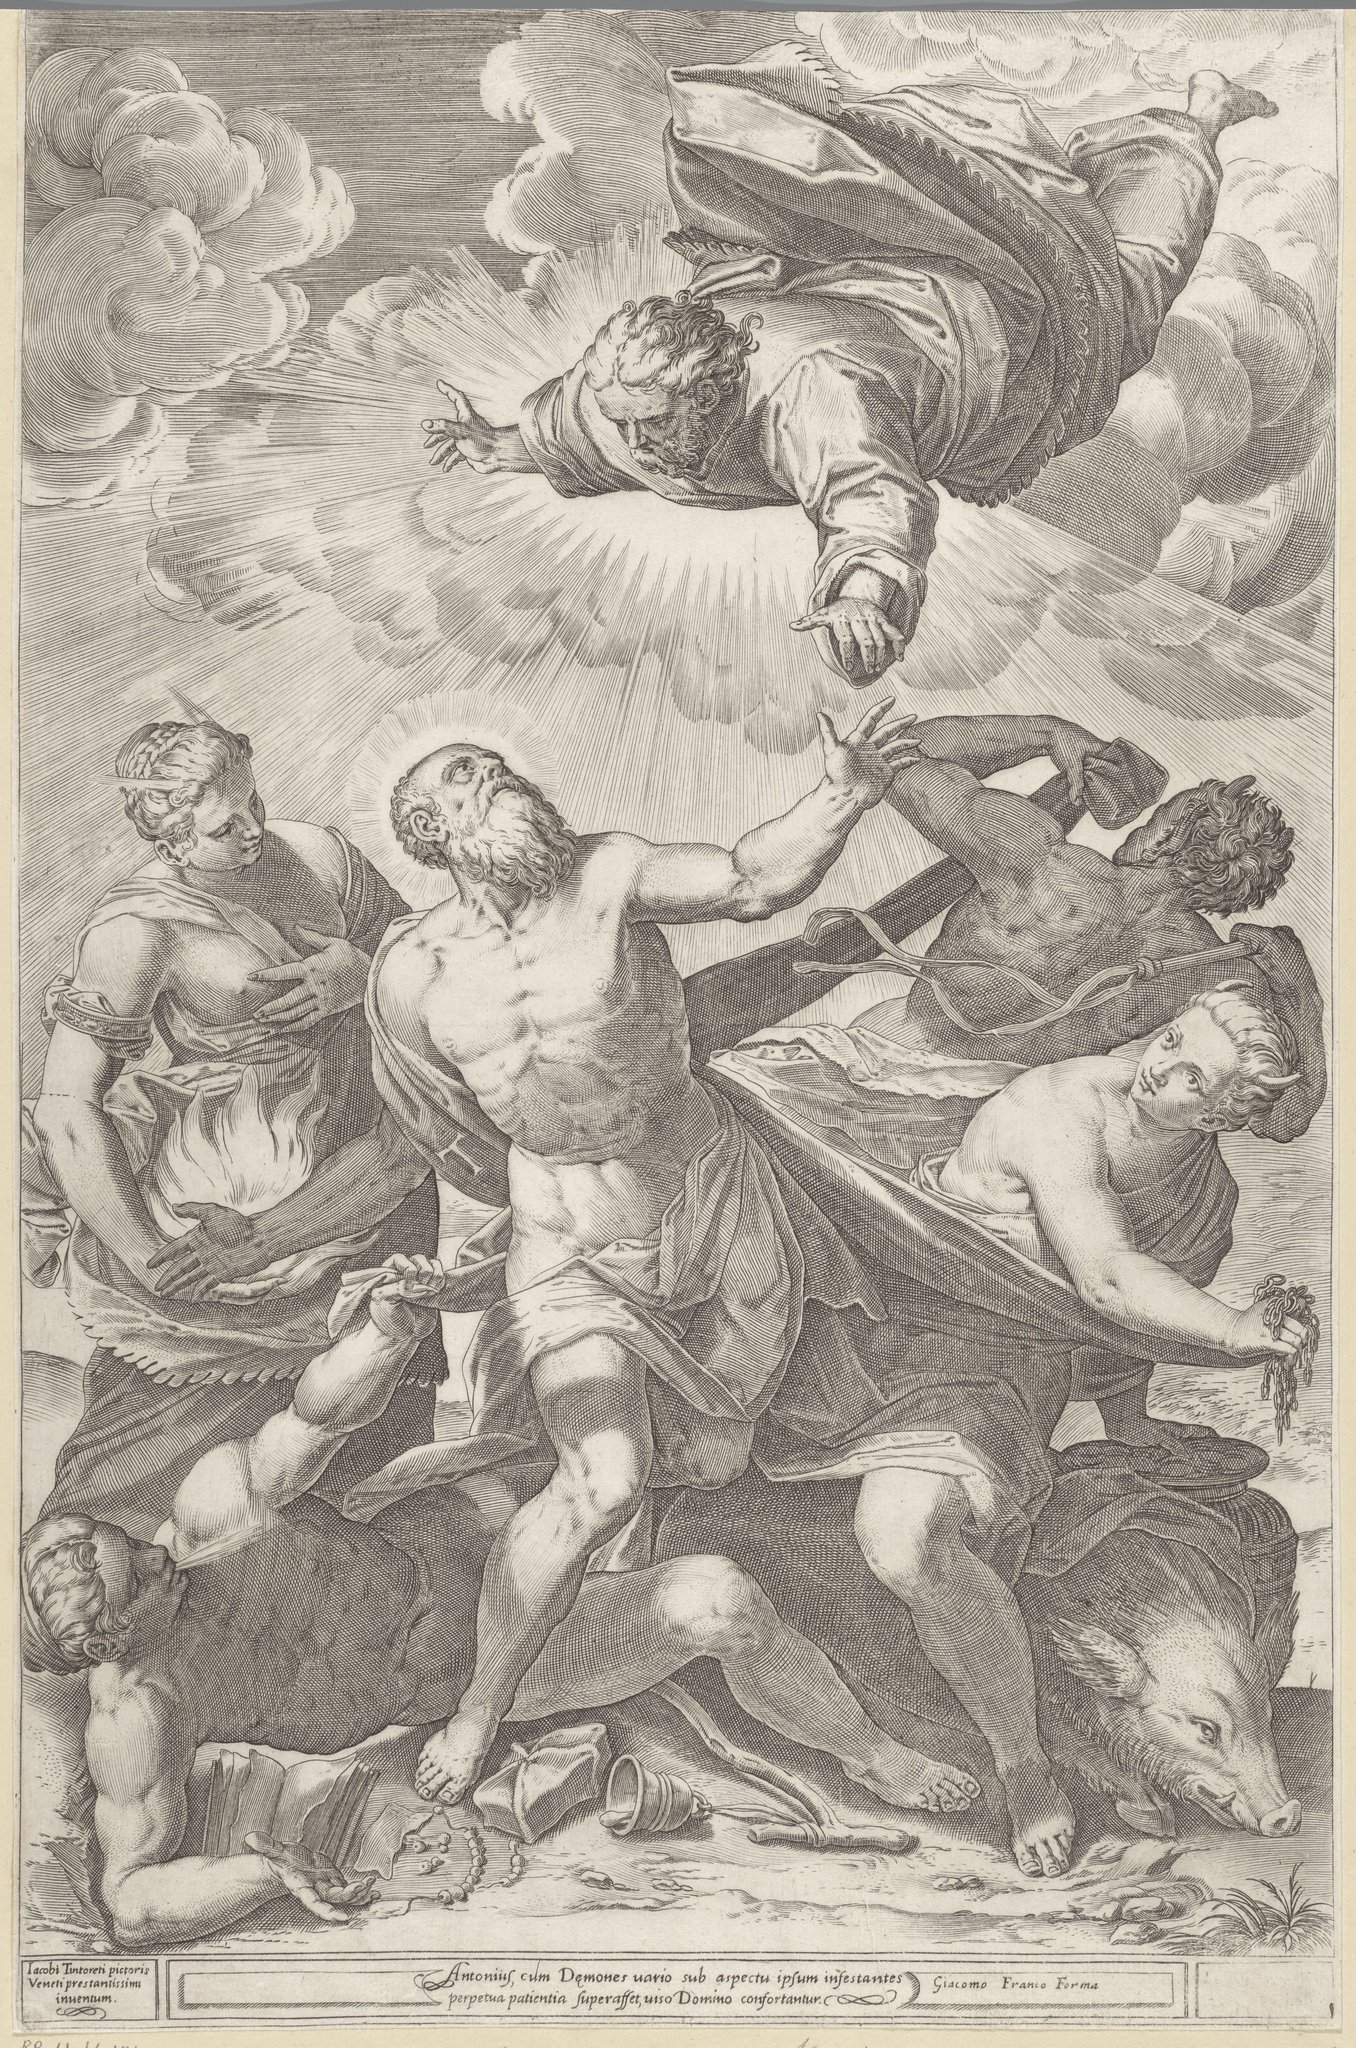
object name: print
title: Verzoeking van de heilige Antonius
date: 1567-1602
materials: paper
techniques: engraving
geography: venice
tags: god the father, temptations of st. antony abbot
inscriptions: collector's mark: Lugt 10, collector's mark: Lugt 11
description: De heilige Antonius samen met vier gehoornde vrouwen in een landschap. De vrouwen trekken hem aan zijn kleed en belagen hem op allerlei manieren. Rechts het varken. Boven verschijnt God de Vader.